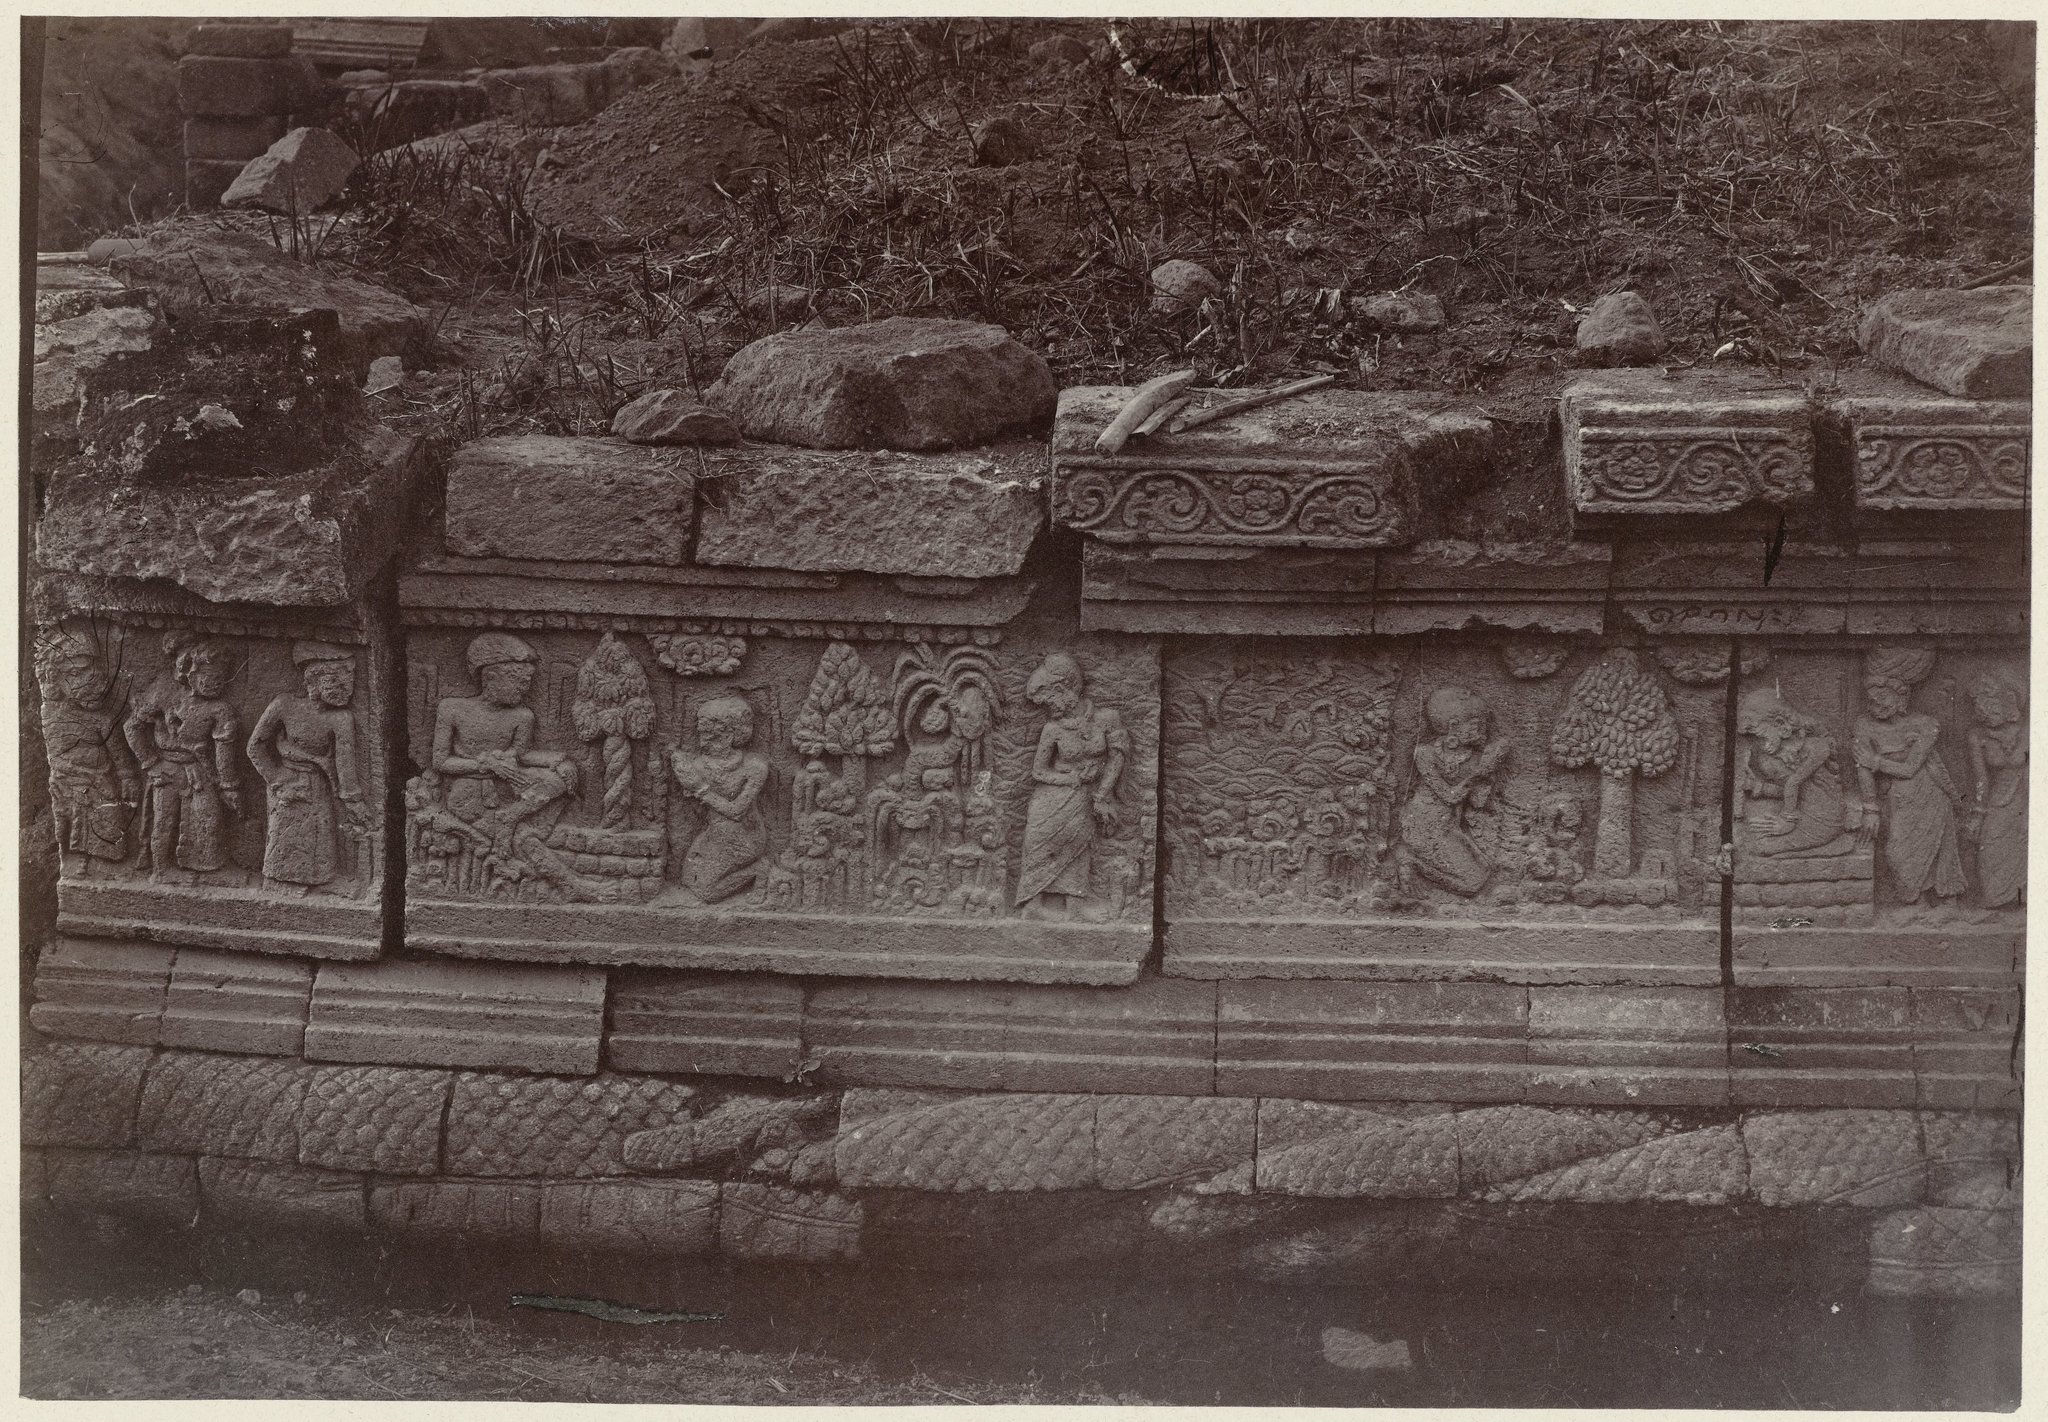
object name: photograph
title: Basrelief op het voetstuk eener pendopo (?) (zuidzijde). Panataran (r. Kediri)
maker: isidore kinsbergen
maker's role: fotograaf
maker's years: 1821-1905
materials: cardboard, paper, photographic support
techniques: albumen print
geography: java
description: Candi Panataran (Temple Complex), Pendopo Terrace, unidentified reliefs 75-78 (inscription above 78 reads turigaluh), south side. Panataran, Blitar district, East Java province, 1375 AD